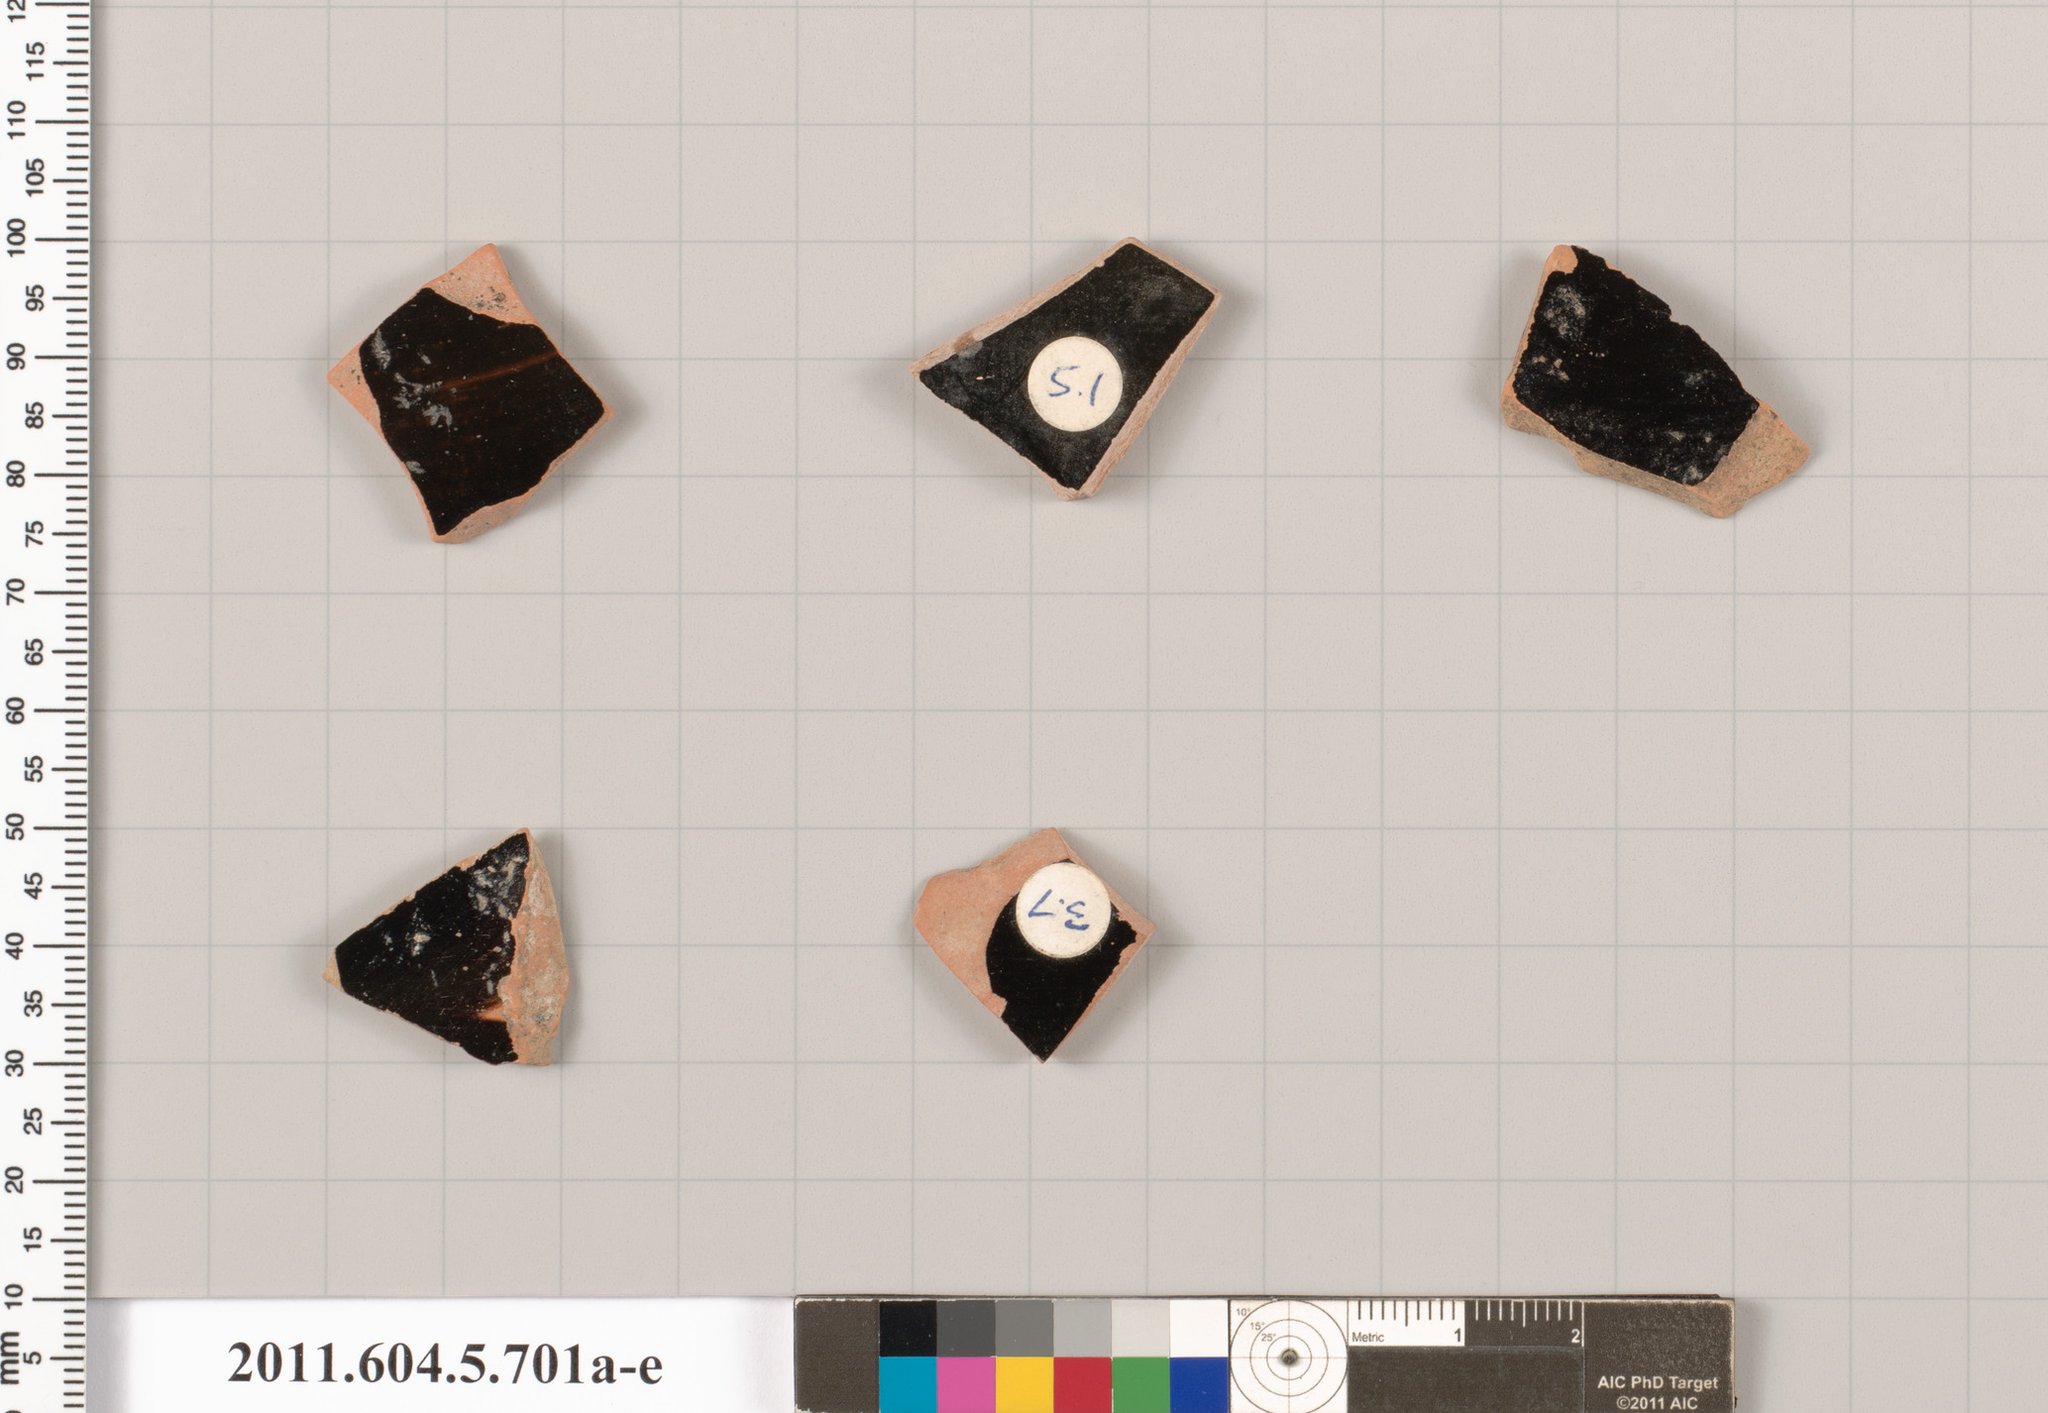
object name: kylix fragment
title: Terracotta fragments of kylikes (drinking cups)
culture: greek, attic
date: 600-401 BCE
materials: terracotta